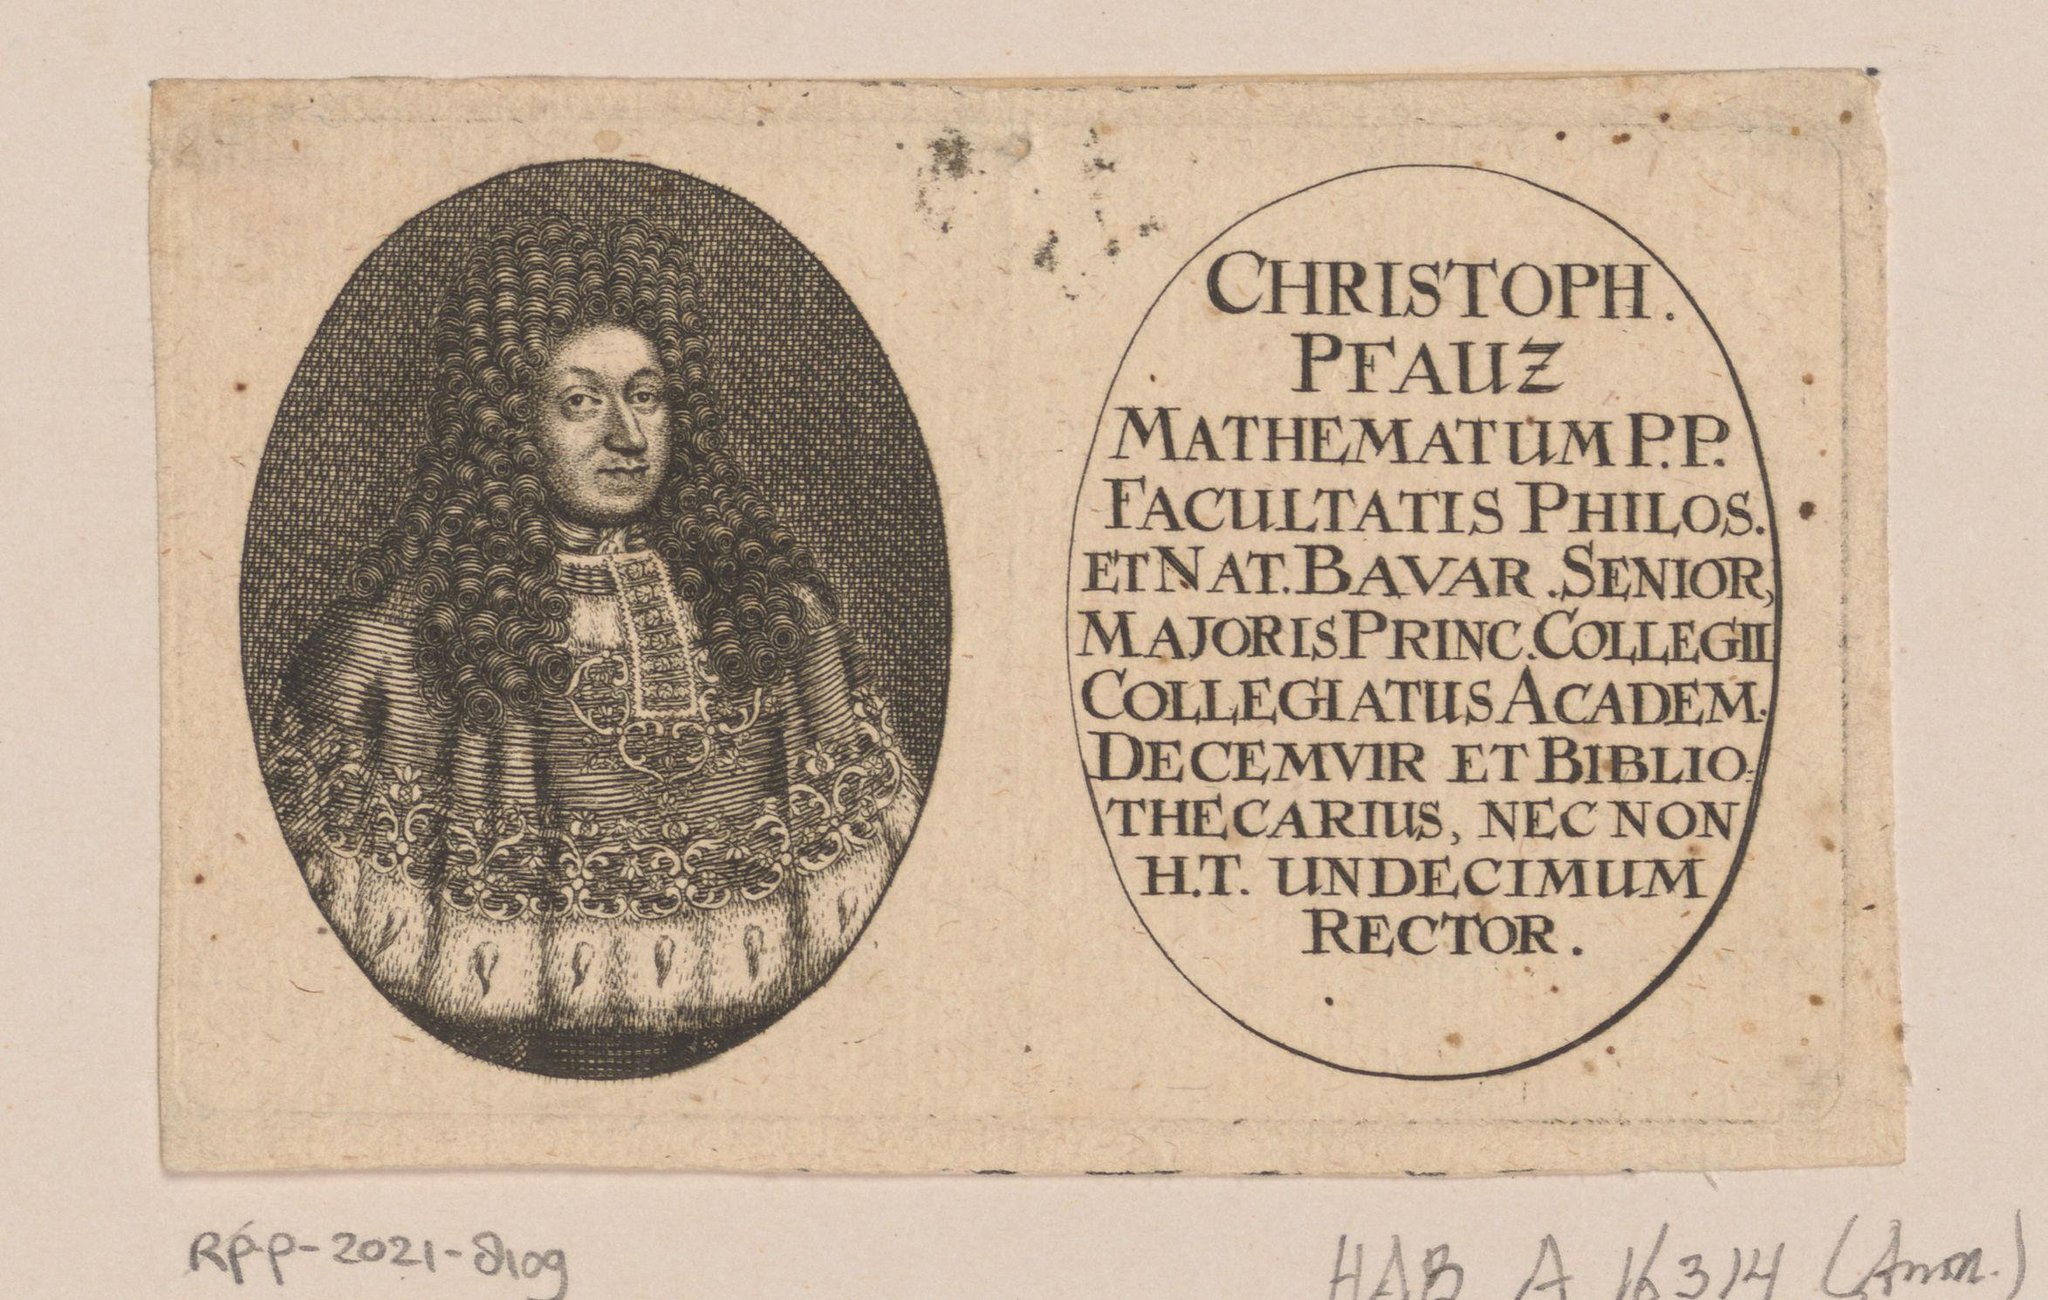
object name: print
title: Portret van Christoph Pfautz II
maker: Anonymous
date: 1691-1724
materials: paper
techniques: engraving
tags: adult man, historical persons